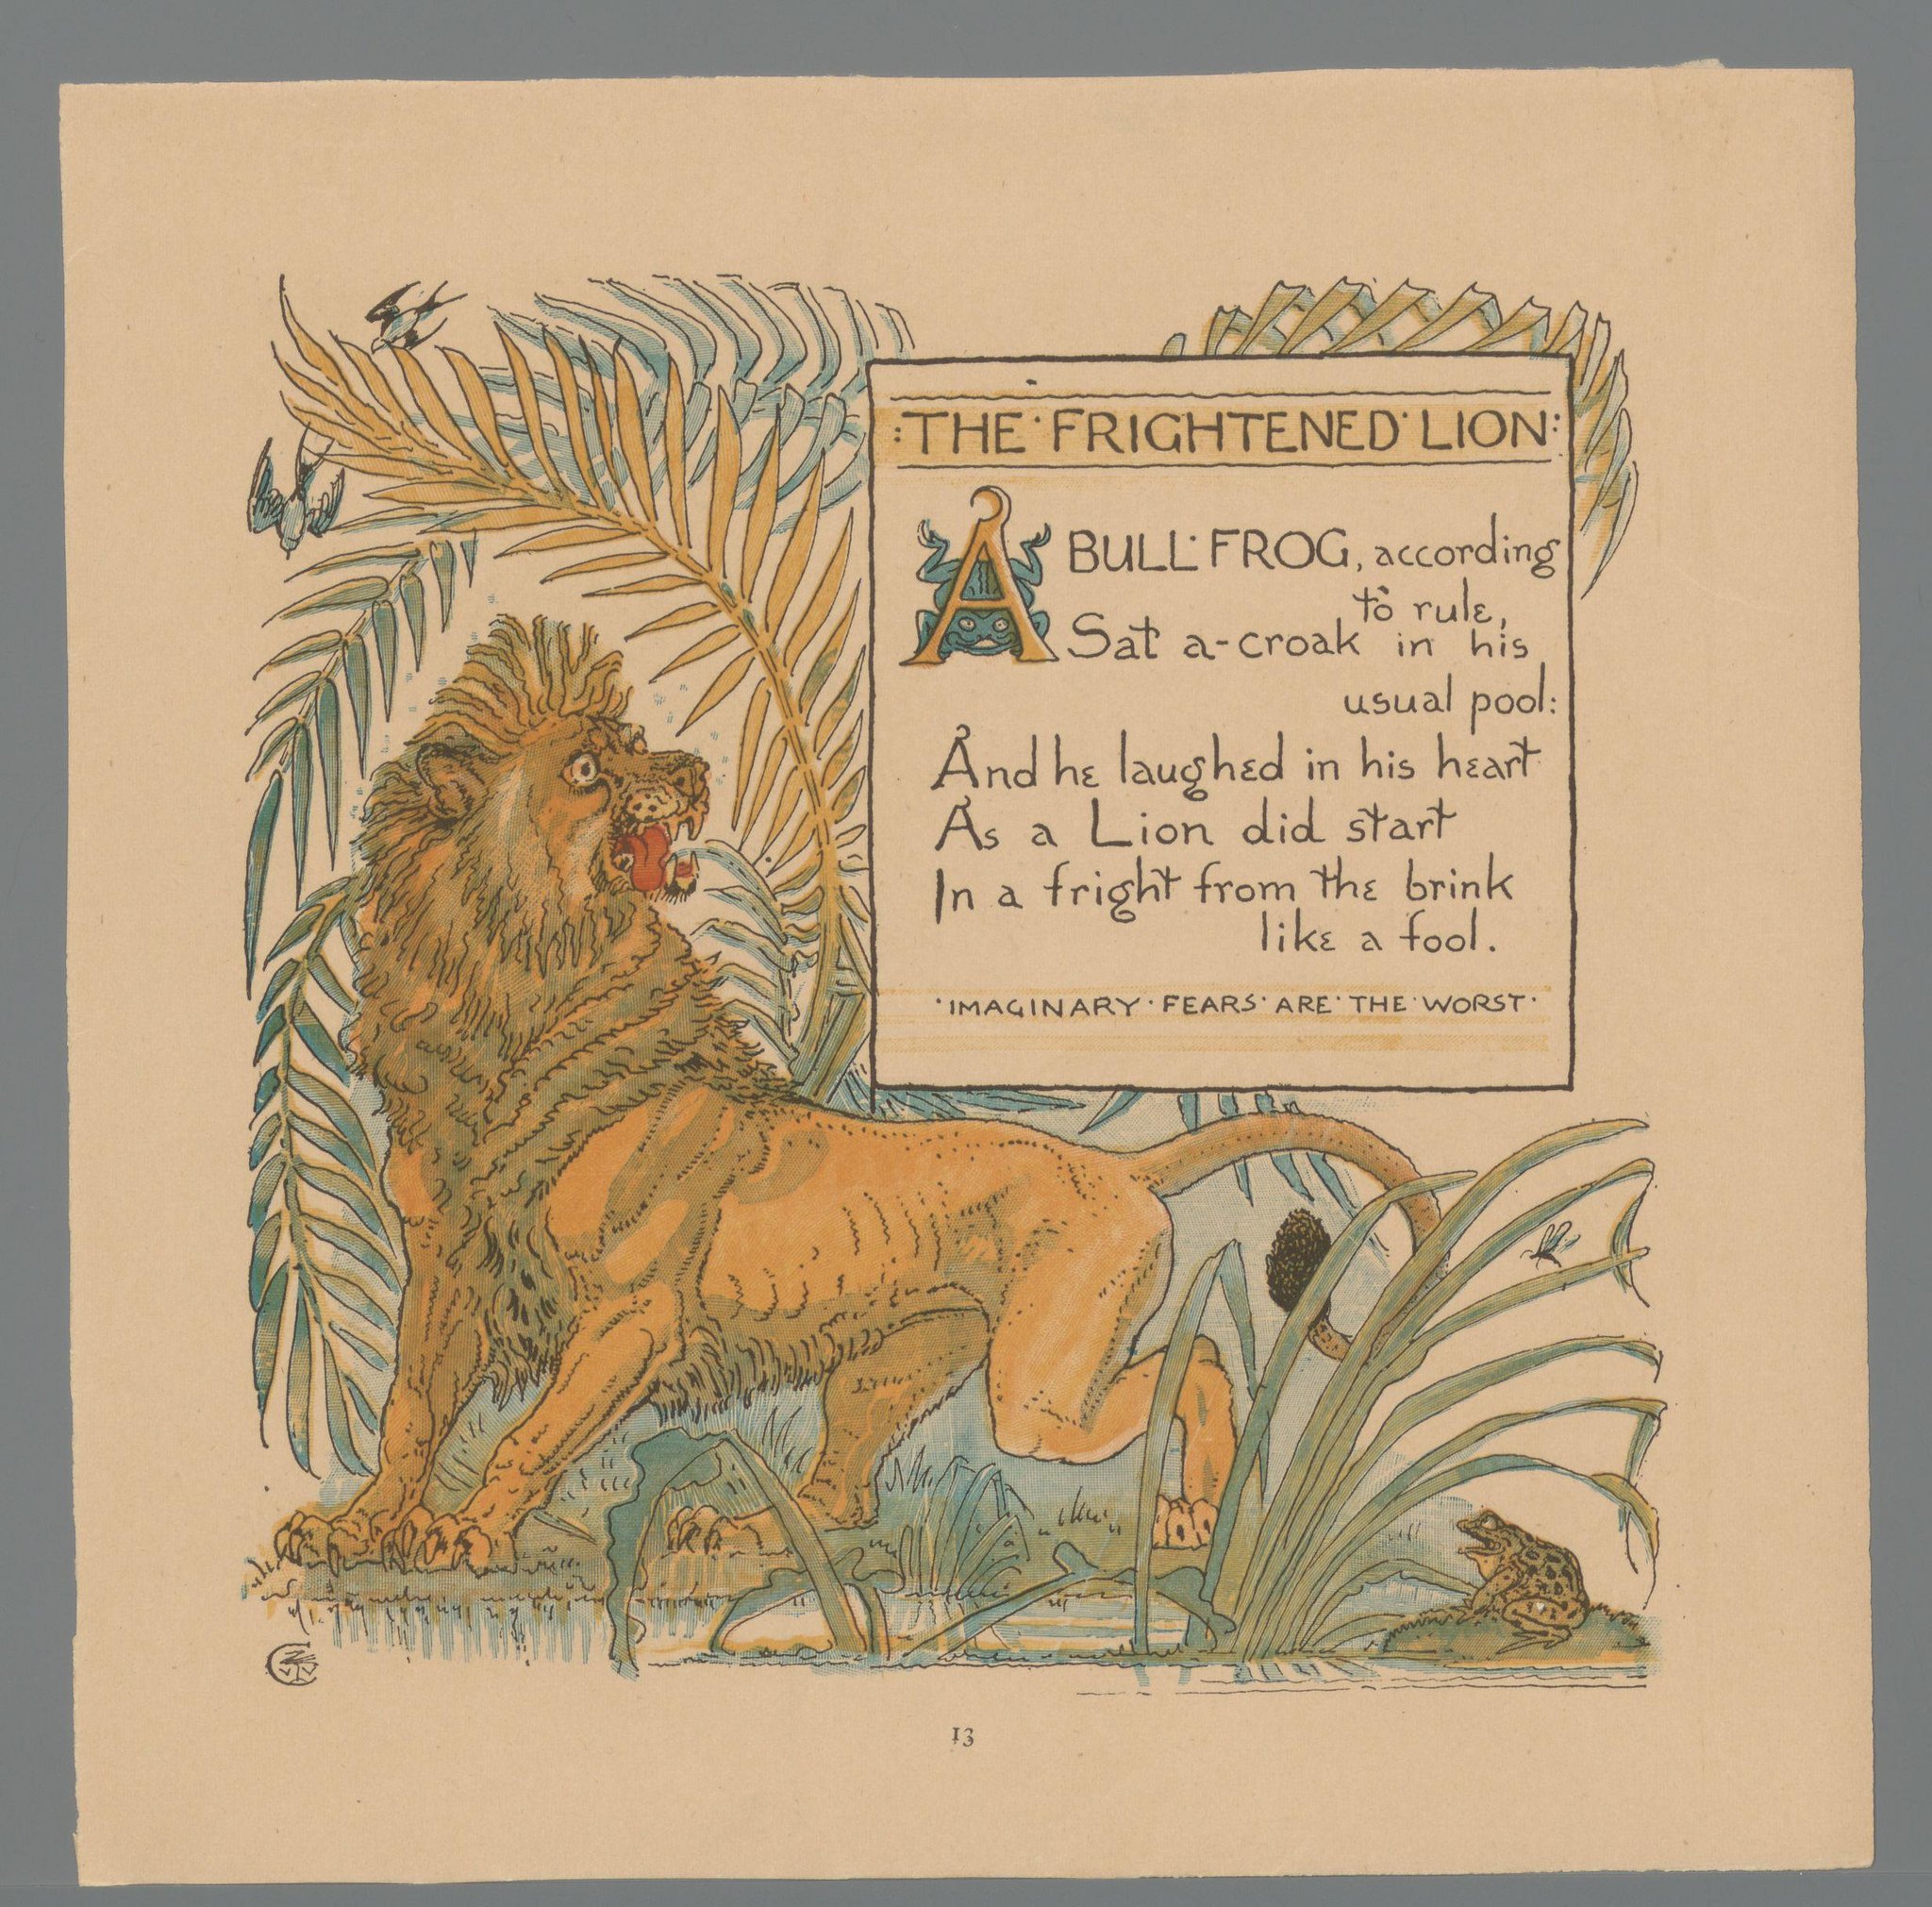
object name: book illustration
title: The frightened lion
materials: paper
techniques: wood engraving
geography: london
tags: tailless amphibians: frog, water course, beasts of prey, predatory animals: lion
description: Prent uit: The baby's own Aesop being the fables condensed in rhyme. Londen: Routledge & Sons, 1887. Of een latere uitgave.